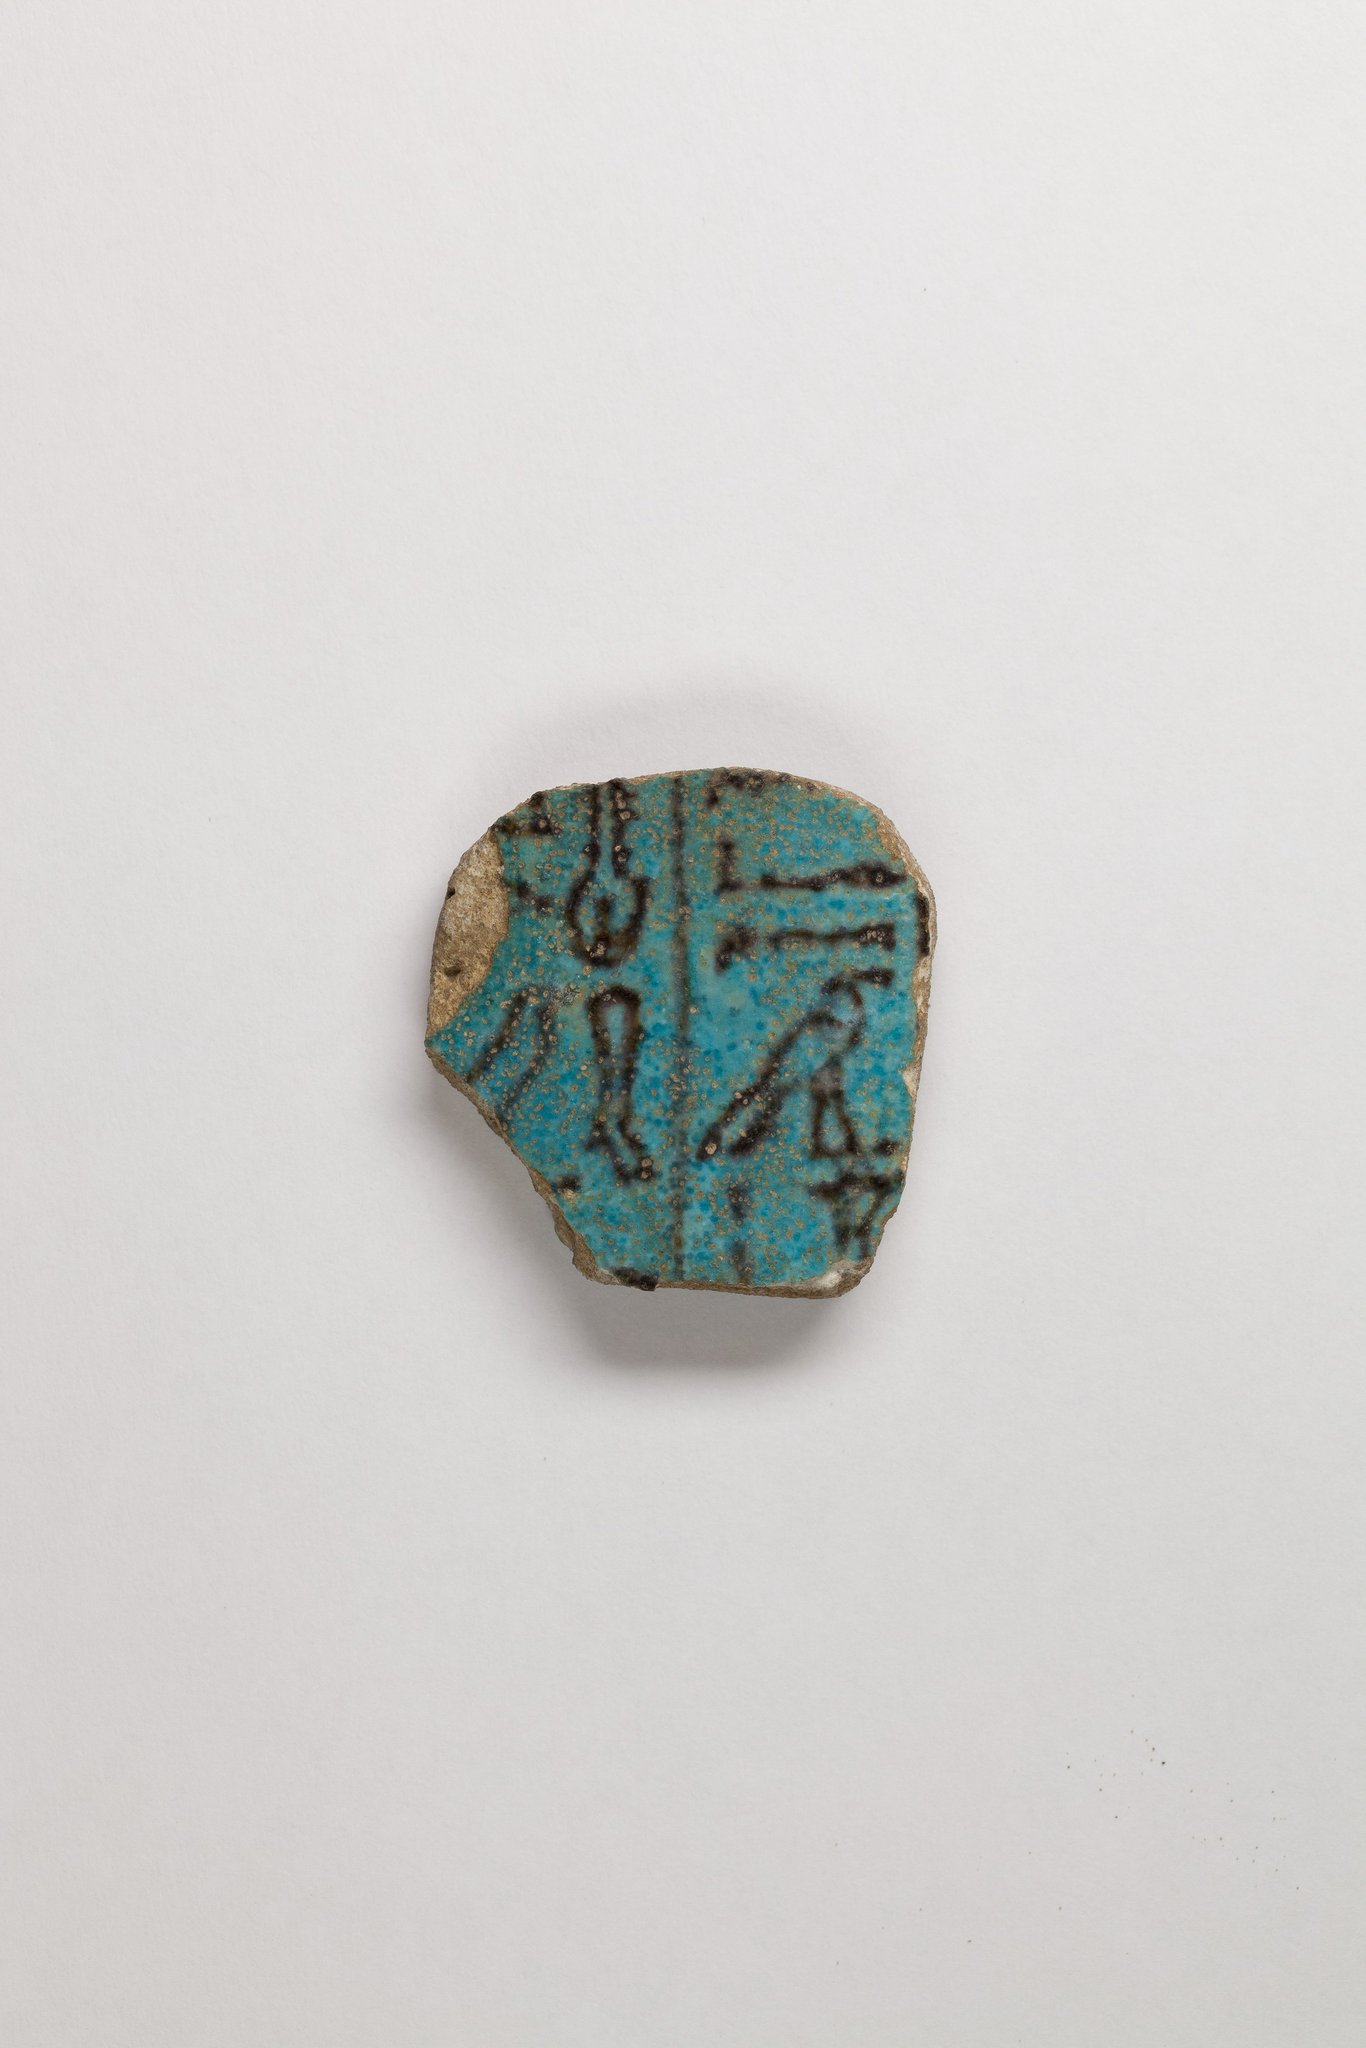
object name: vase fragment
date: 1981-1640 BCE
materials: faience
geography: egypt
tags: hieroglyphs